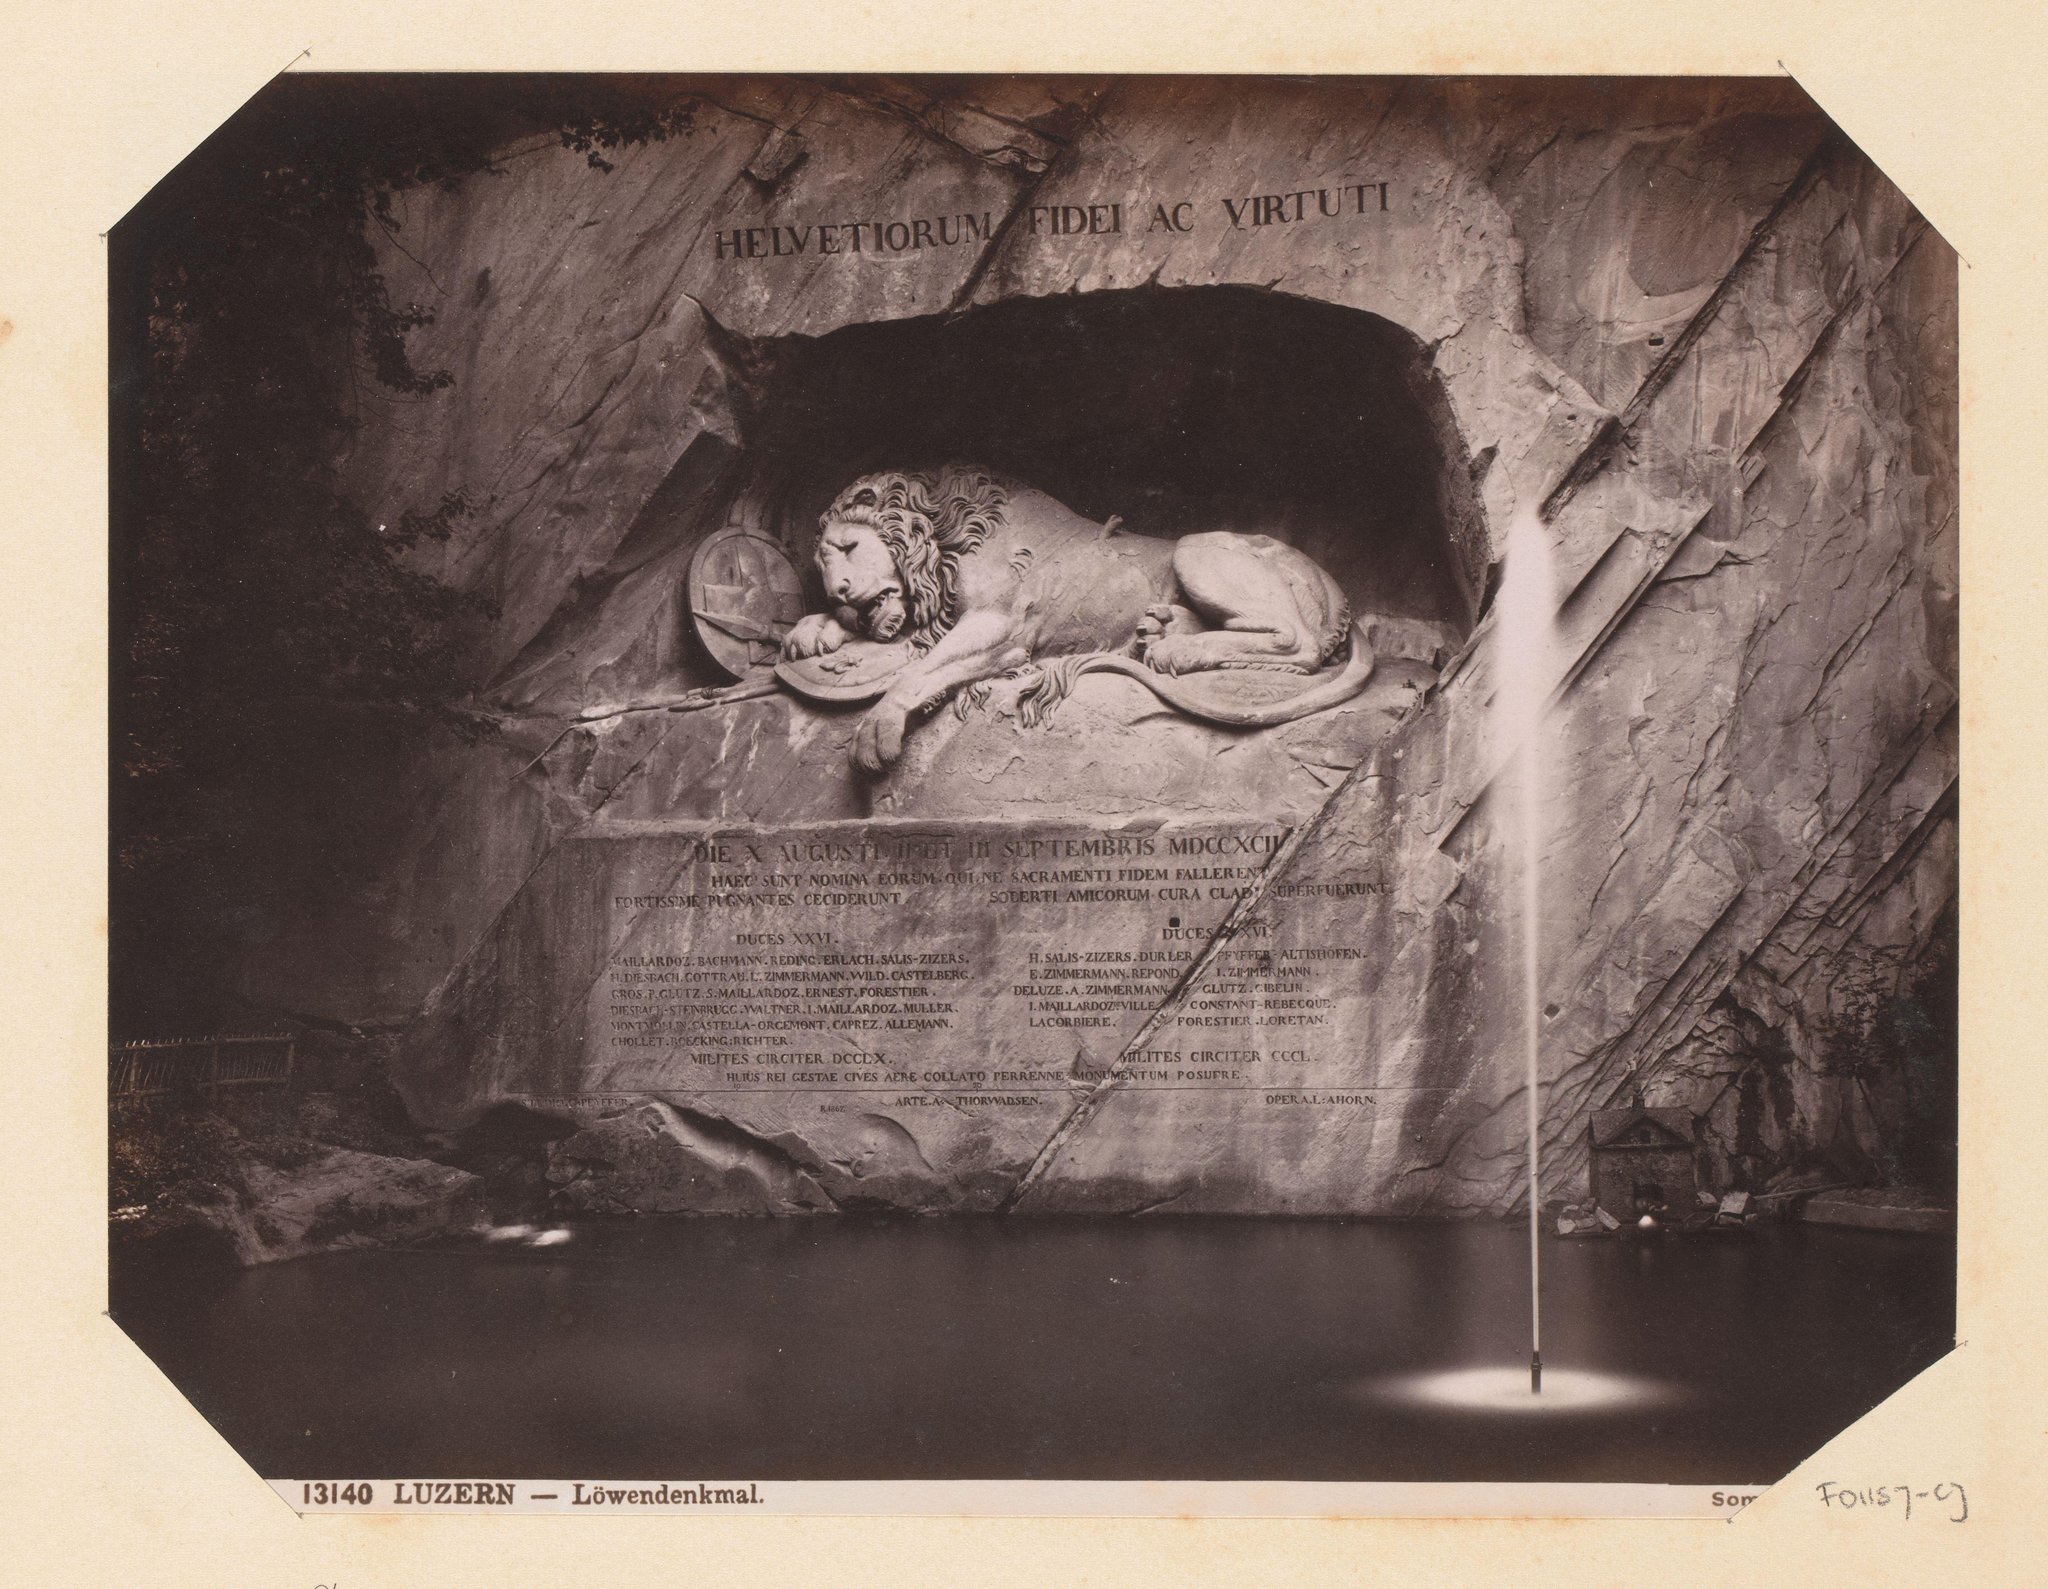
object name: album leaf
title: Leeuwenmonument te Luzern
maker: giorgio sommer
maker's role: fotograaf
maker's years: 1834-1914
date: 1885-1892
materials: photographic support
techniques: albumen print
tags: sculpture, rocks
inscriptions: annotation: ‘Lucerene - Löwendenkmal’, number: ‘13140’